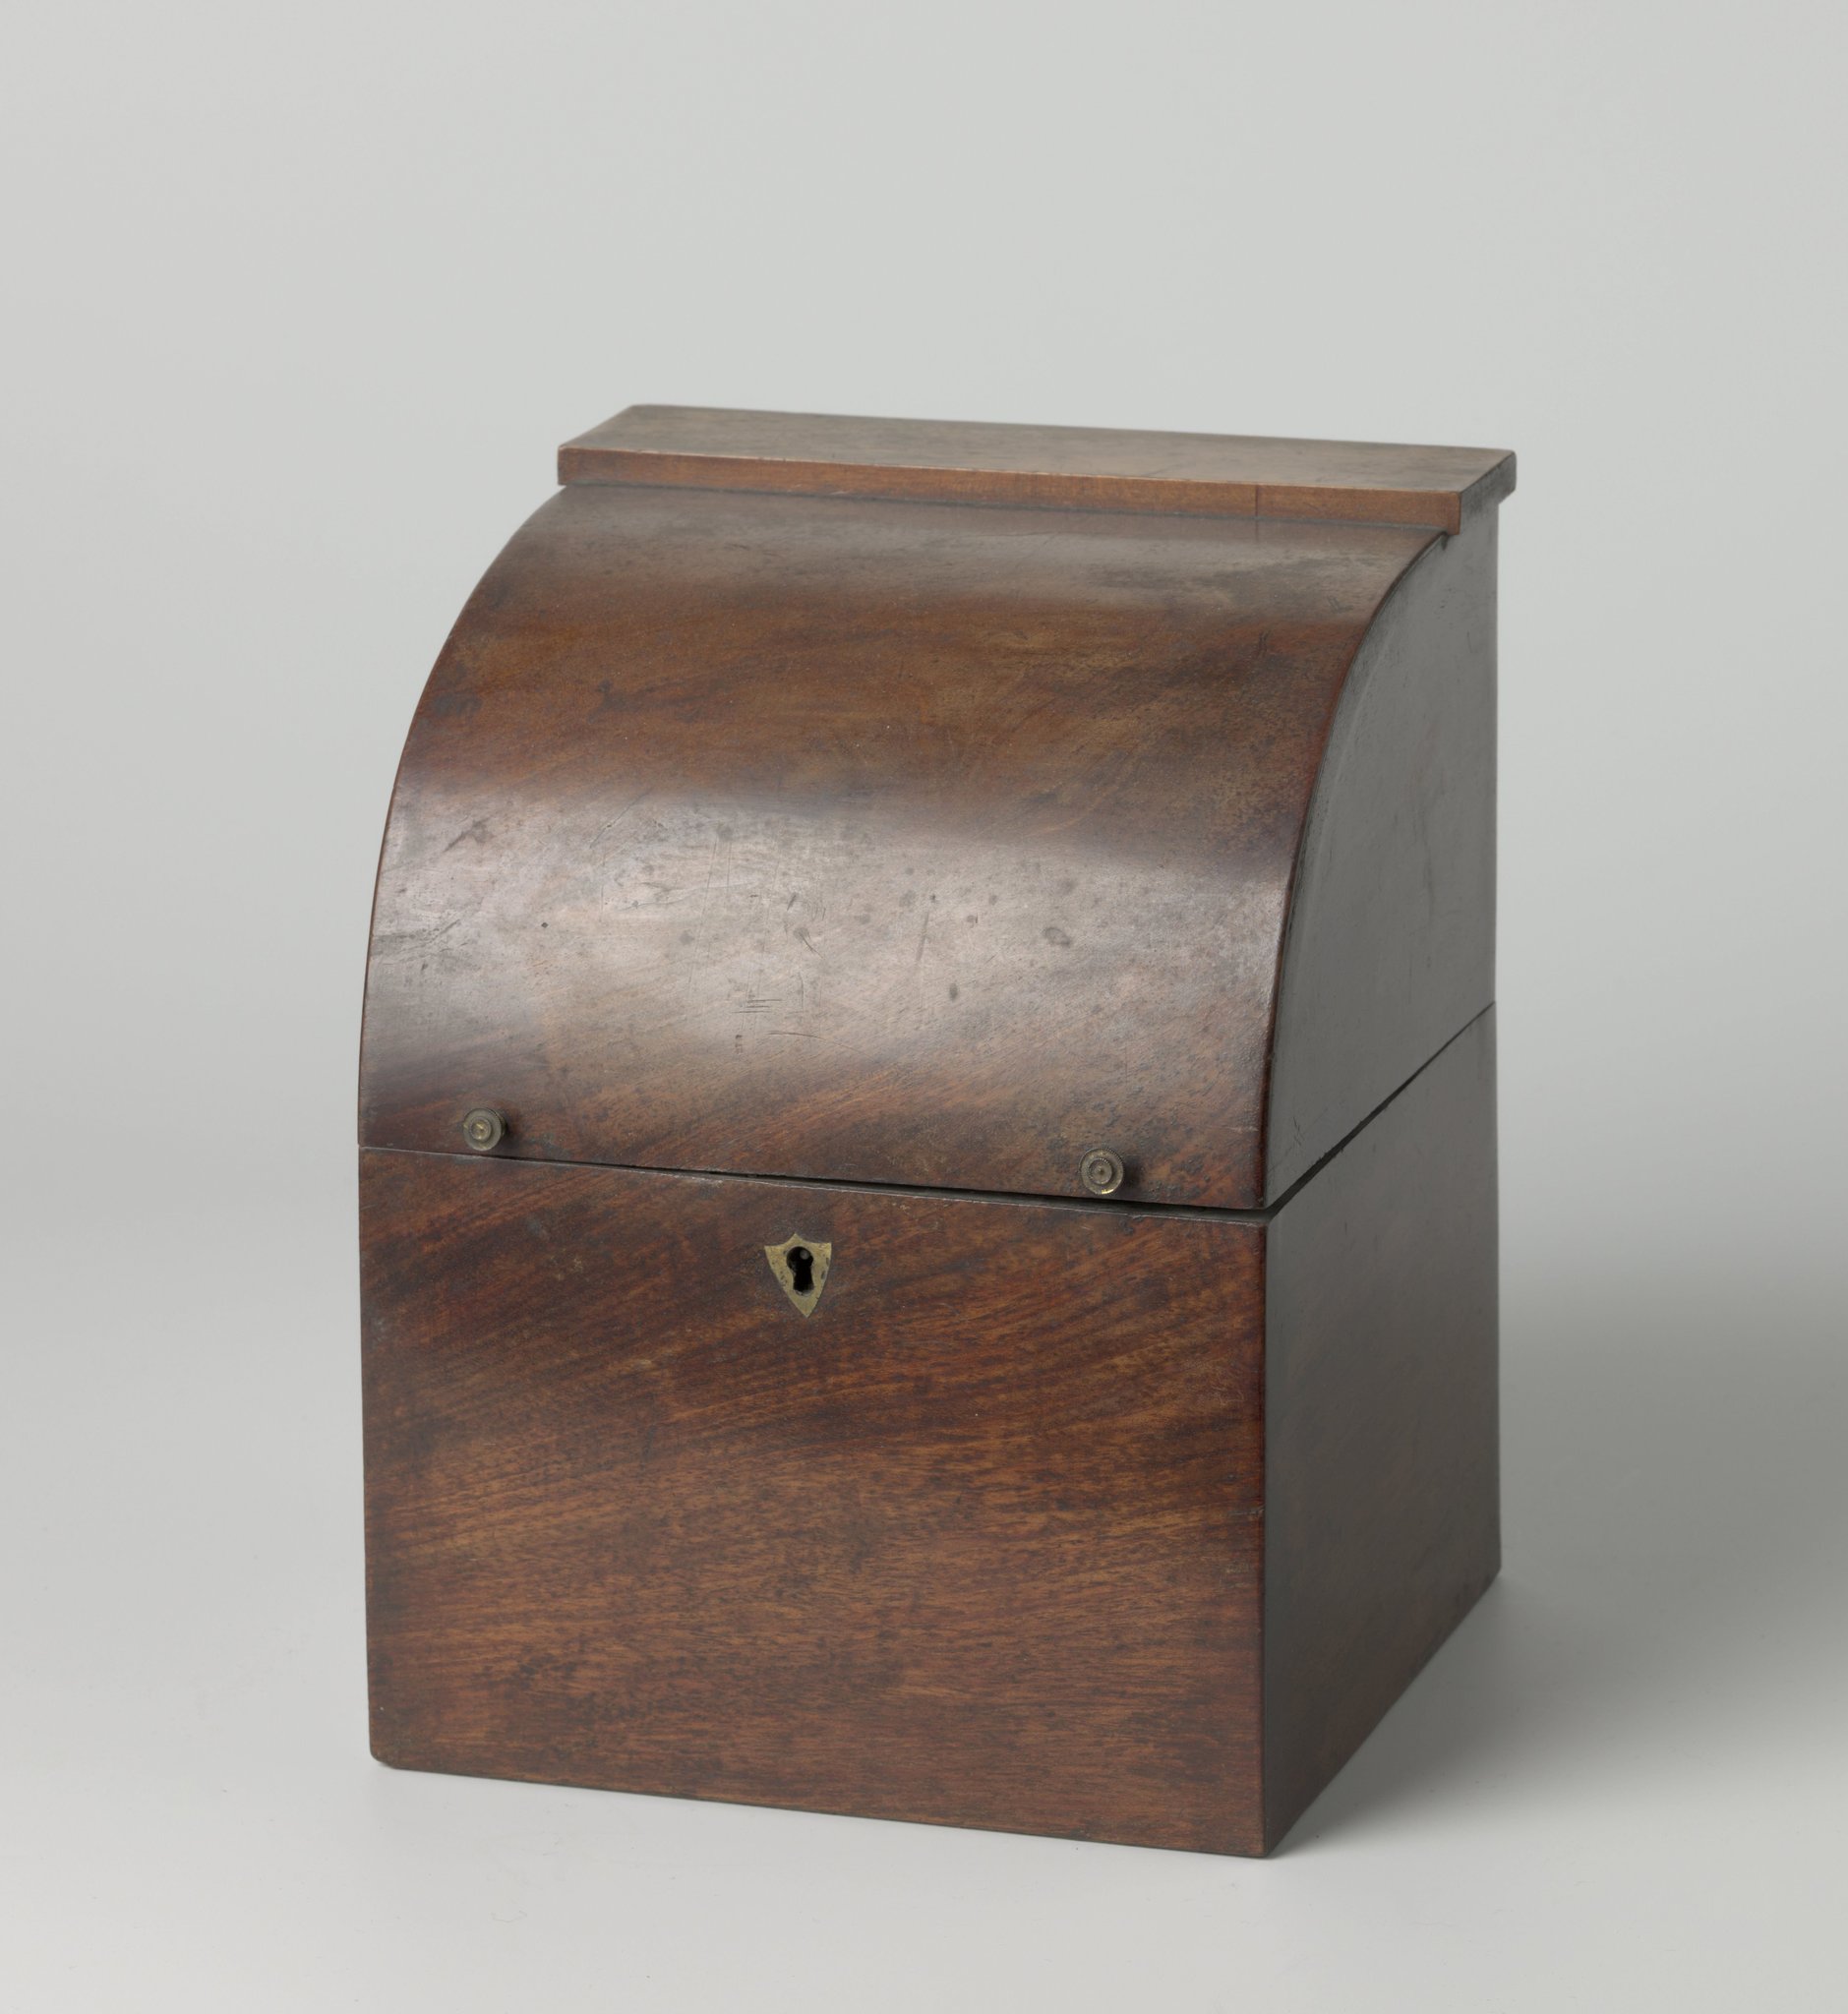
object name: cellaret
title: Likeurkeldertje van mahoniehout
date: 1750-1800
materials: glass, wood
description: Likeurkeldertje van mahoniehout voor 4 flessen en een glas. Het glas en twee flessen ontbreken.